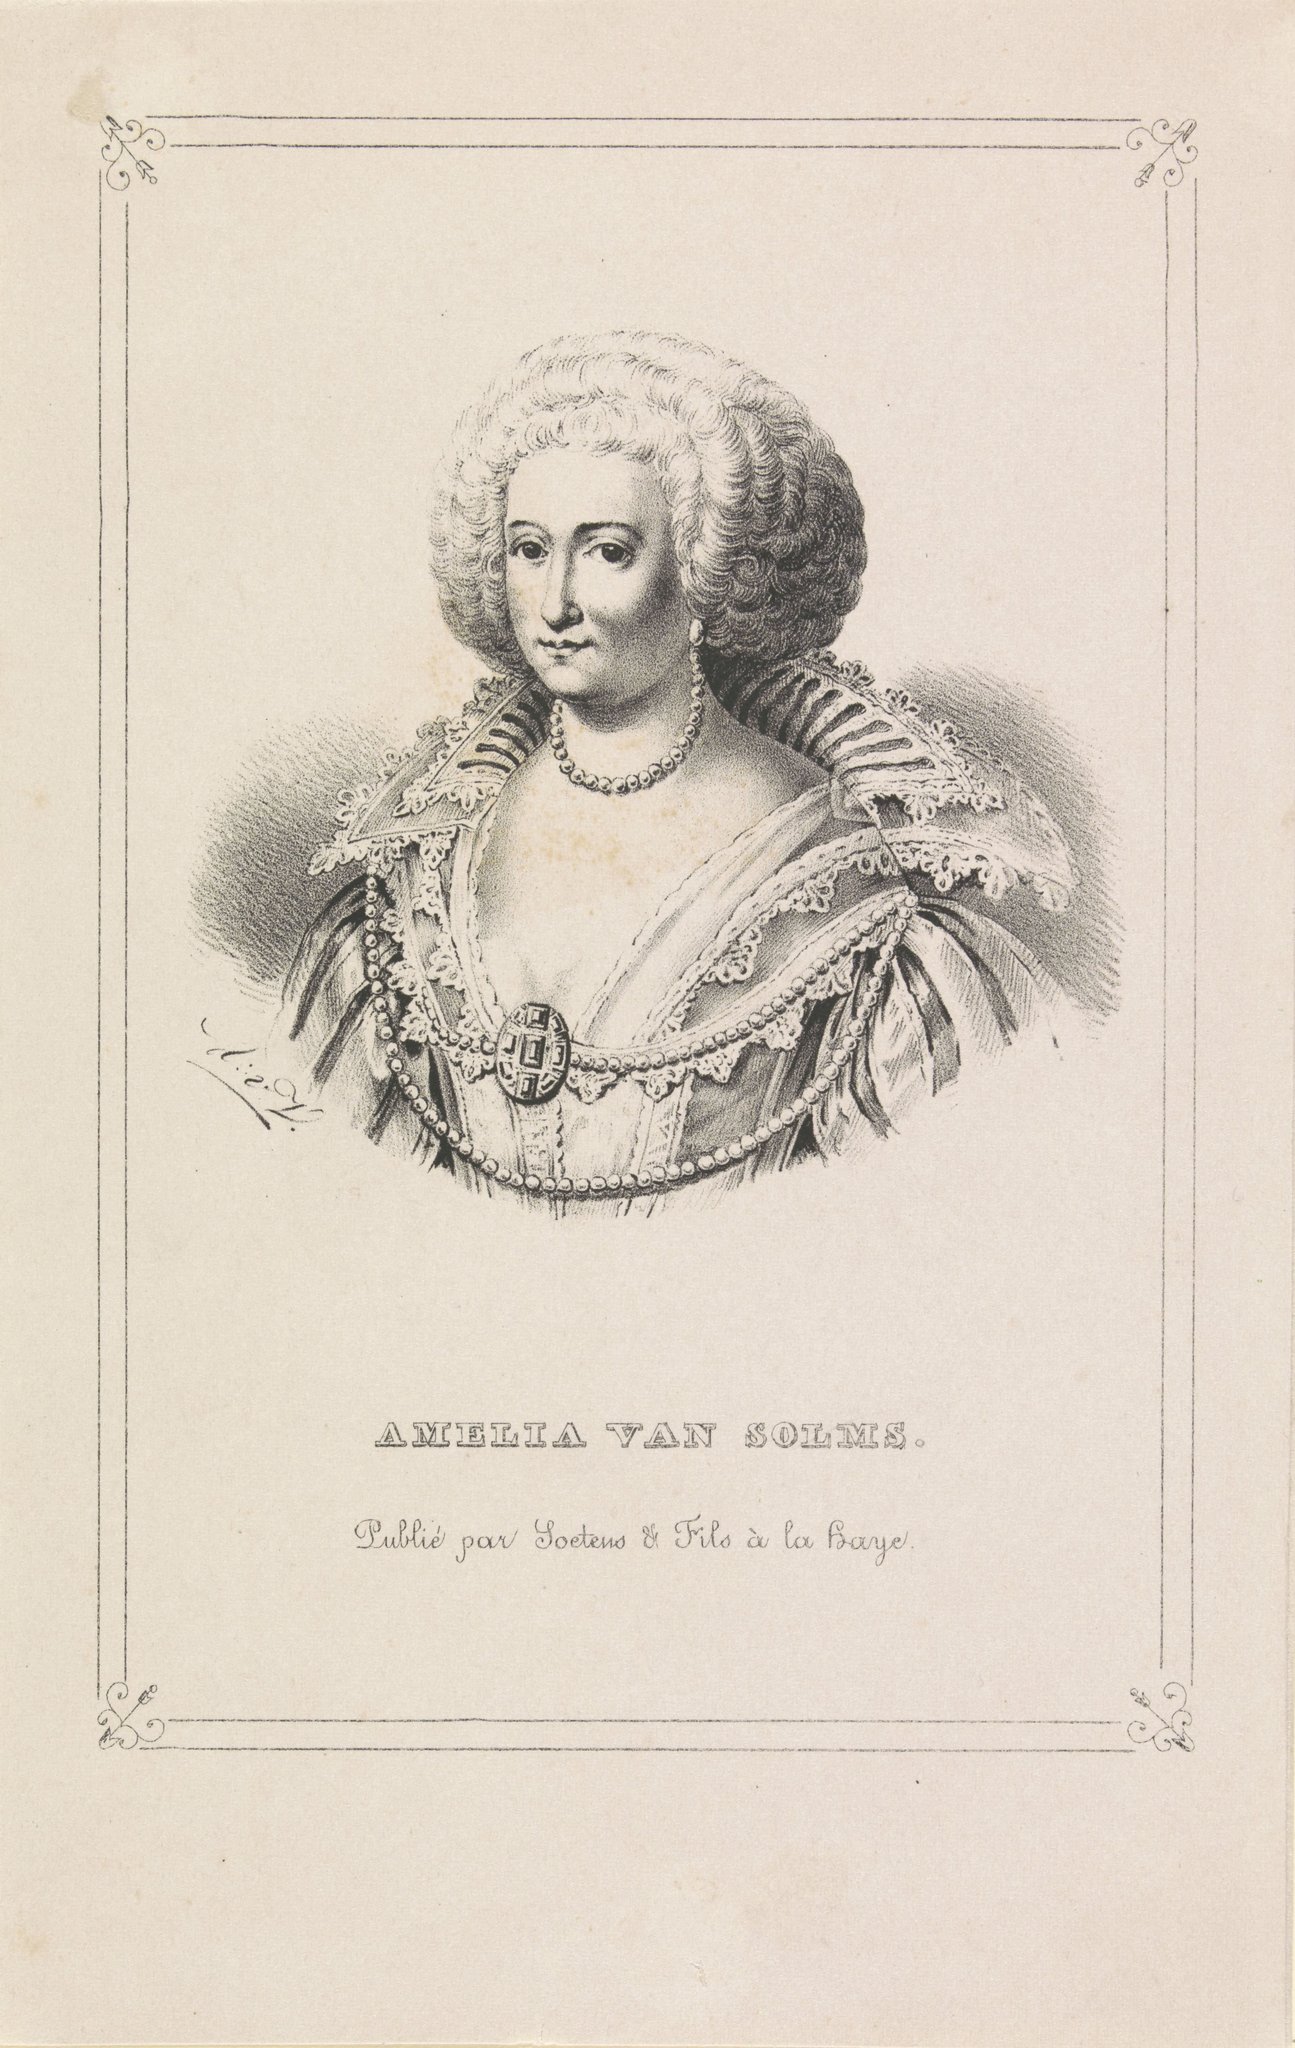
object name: print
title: Portret van Amalia van Solms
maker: anthonie van volkom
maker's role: print maker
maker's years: 1821-1860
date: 1837-1840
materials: paper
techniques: lithograph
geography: the hague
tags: amalia of solms-braunfels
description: Portret van Amalia in een geornamenteerde rechthoek. In de ondermarge haar naam.